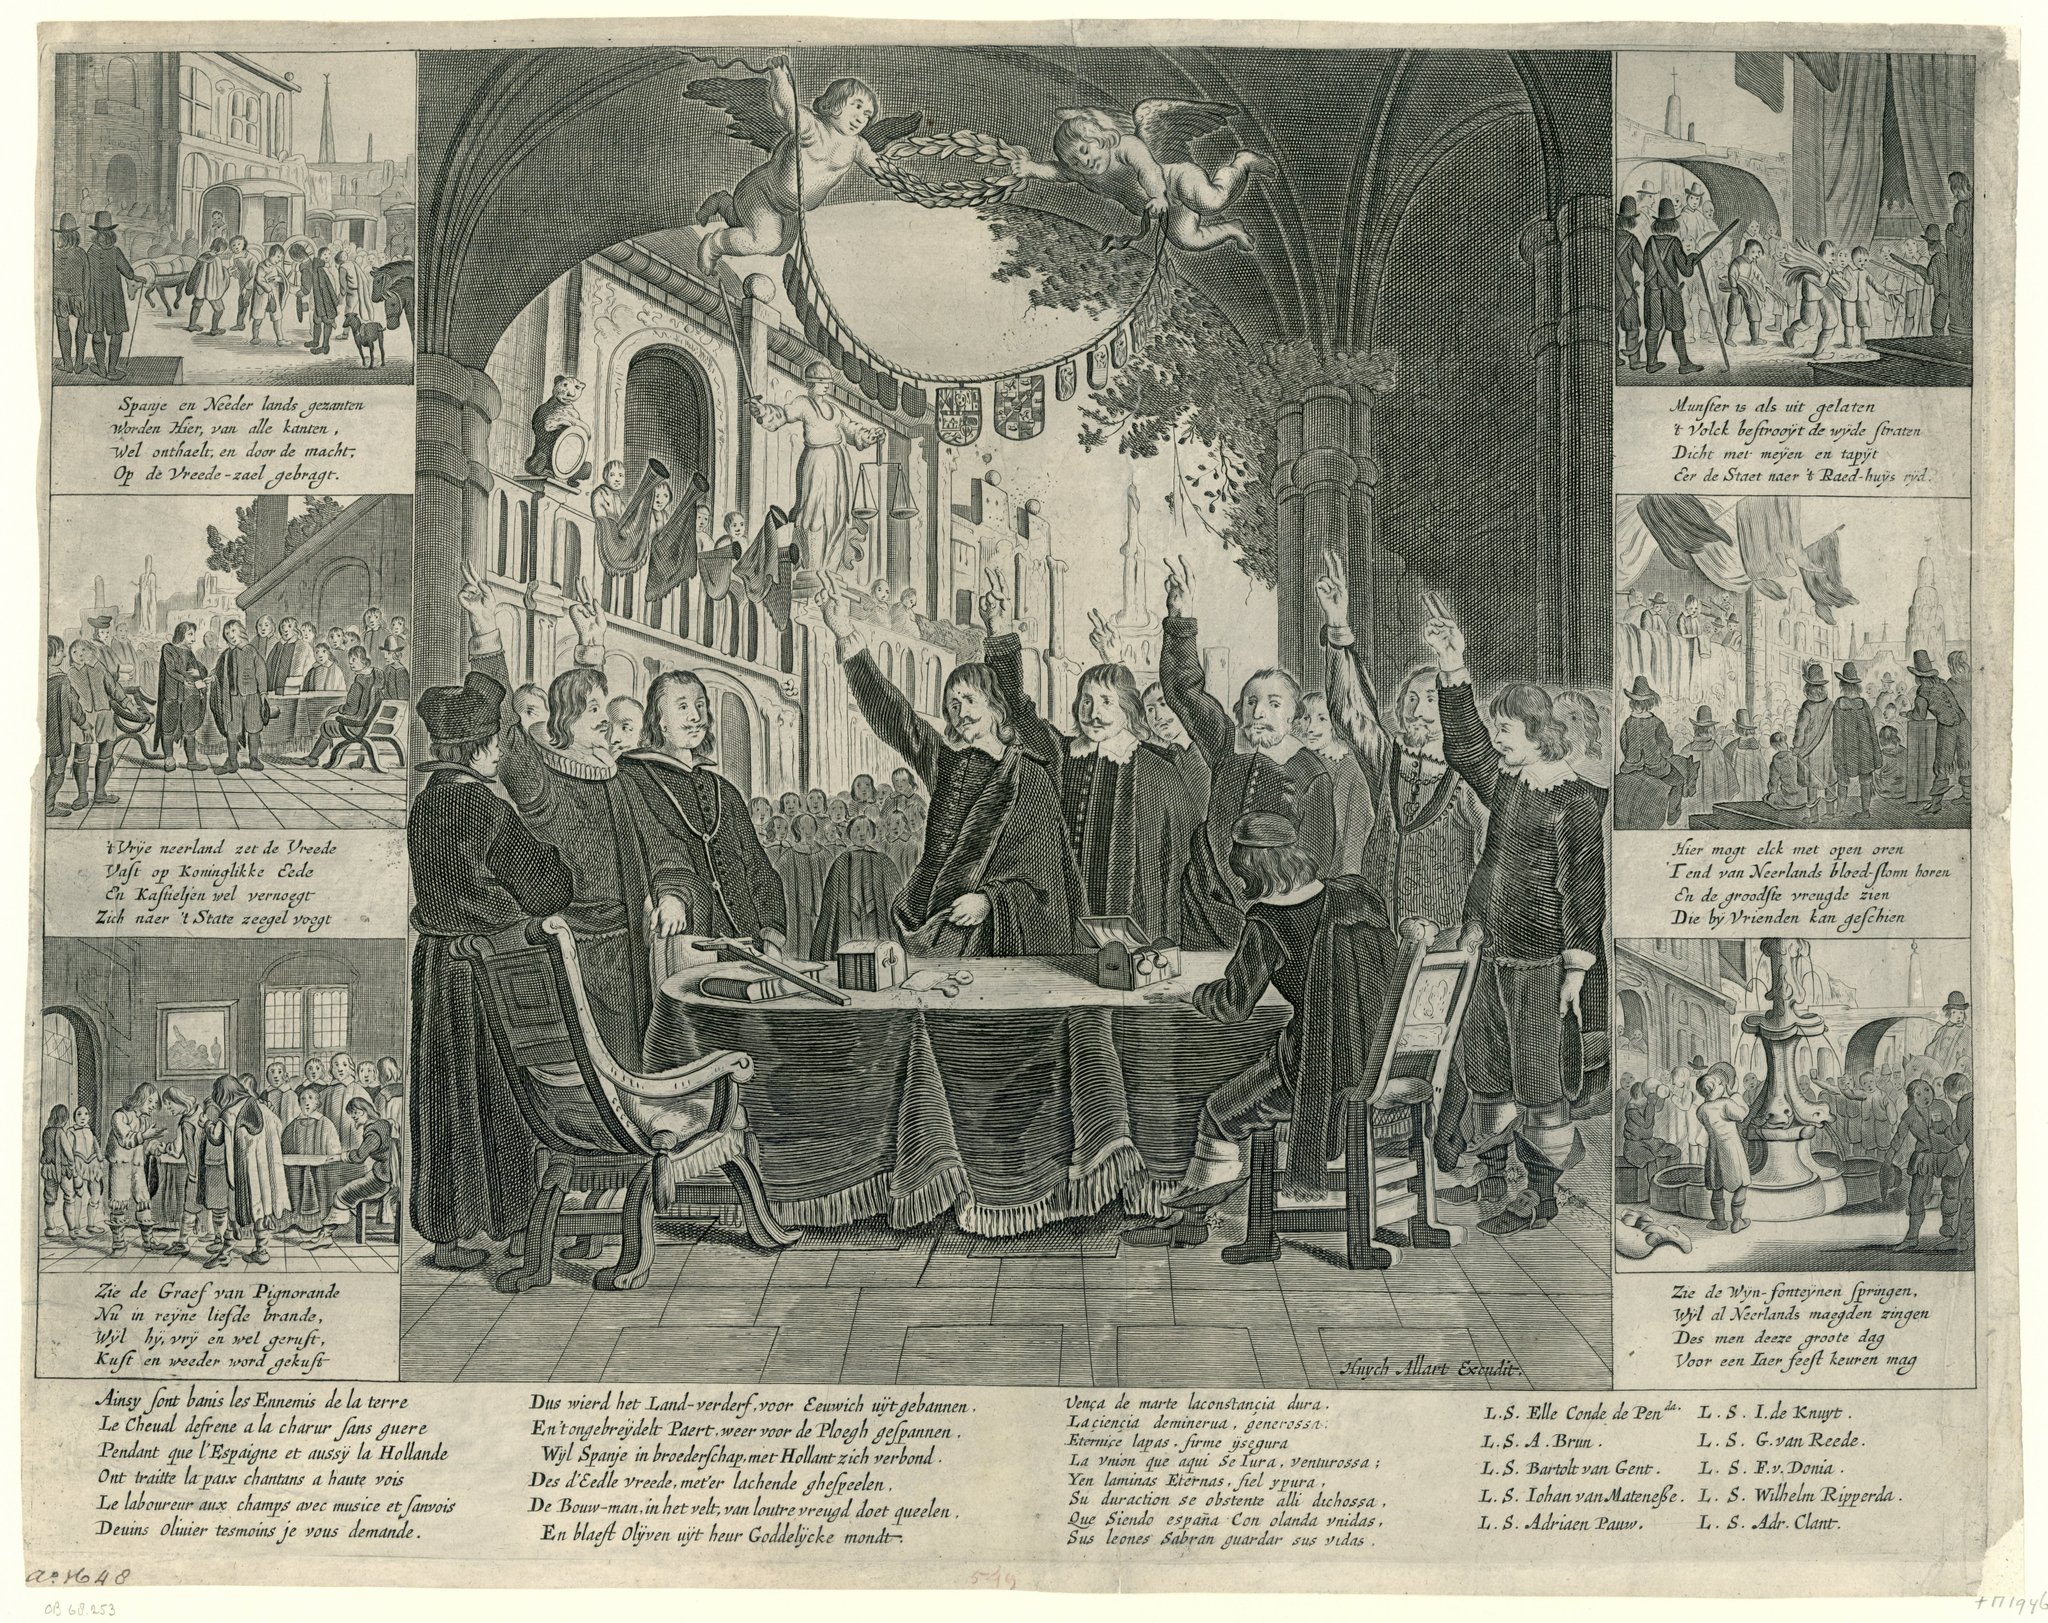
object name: print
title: De beëdiging van de Vrede van Munster, 1648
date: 1648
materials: paper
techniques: engraving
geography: northern netherlands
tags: gaspar de bracamonte y guzman (graaf van peñaranda), amsterdam, the hague, politician, adriaen pauw (1585-1653), utrecht, signing of peace treaty, concluding the peace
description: De Vrede van Munster wordt door de gedelegeerden beëdigd. Zij staan rond een tafel en zweren met omhoog gestoken hand. In de lucht twee putti met een koord met de wapens van de Frederik Hendrik, de Spaanse koning Filips IV en de zeven verenigde provincies. Om de centrale voorstelling staan zes kleinere scènes van eerdere en latere momenten: de aankomst van de afgevaardigden, de vredesonderhandelingen, de bekendmaking van de vrede en het salvoschieten te Munster. Onderaan 3 verzen van 8 regels in het Frans, Nederlands en Spaans en de namen van de afgevaardigden. Afdruk van een versleten en opgewerkte koperplaat.